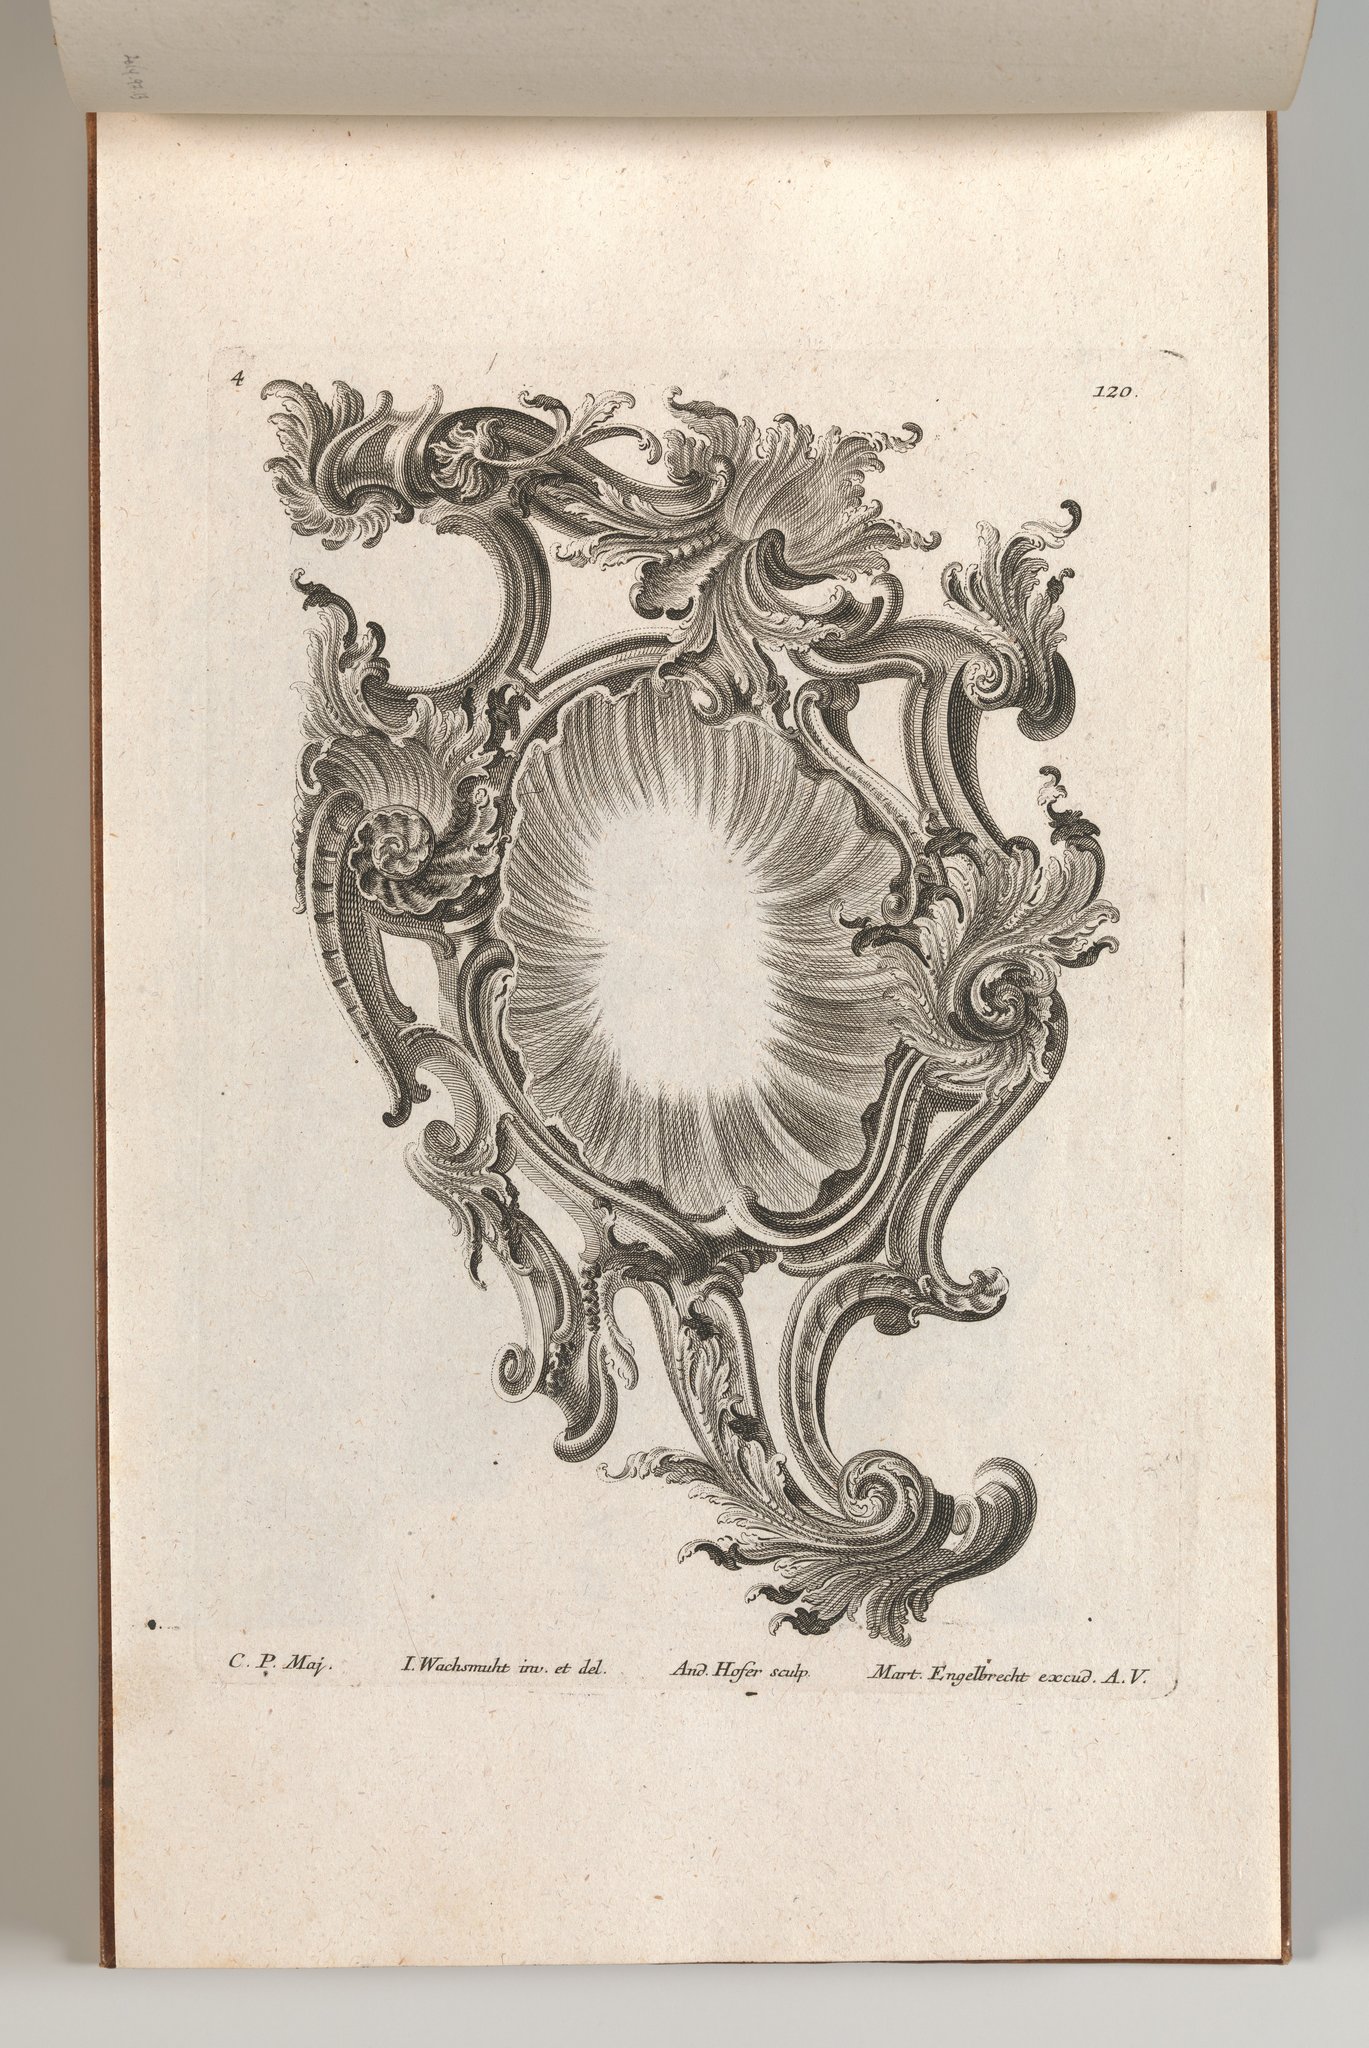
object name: album print ornament architecture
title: Design for a Cartouche, Plate 4 from 'Allerneueste Façon einiger Schild oder Cartouches'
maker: andreas hofer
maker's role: engraver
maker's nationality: central european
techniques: etching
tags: cartouches